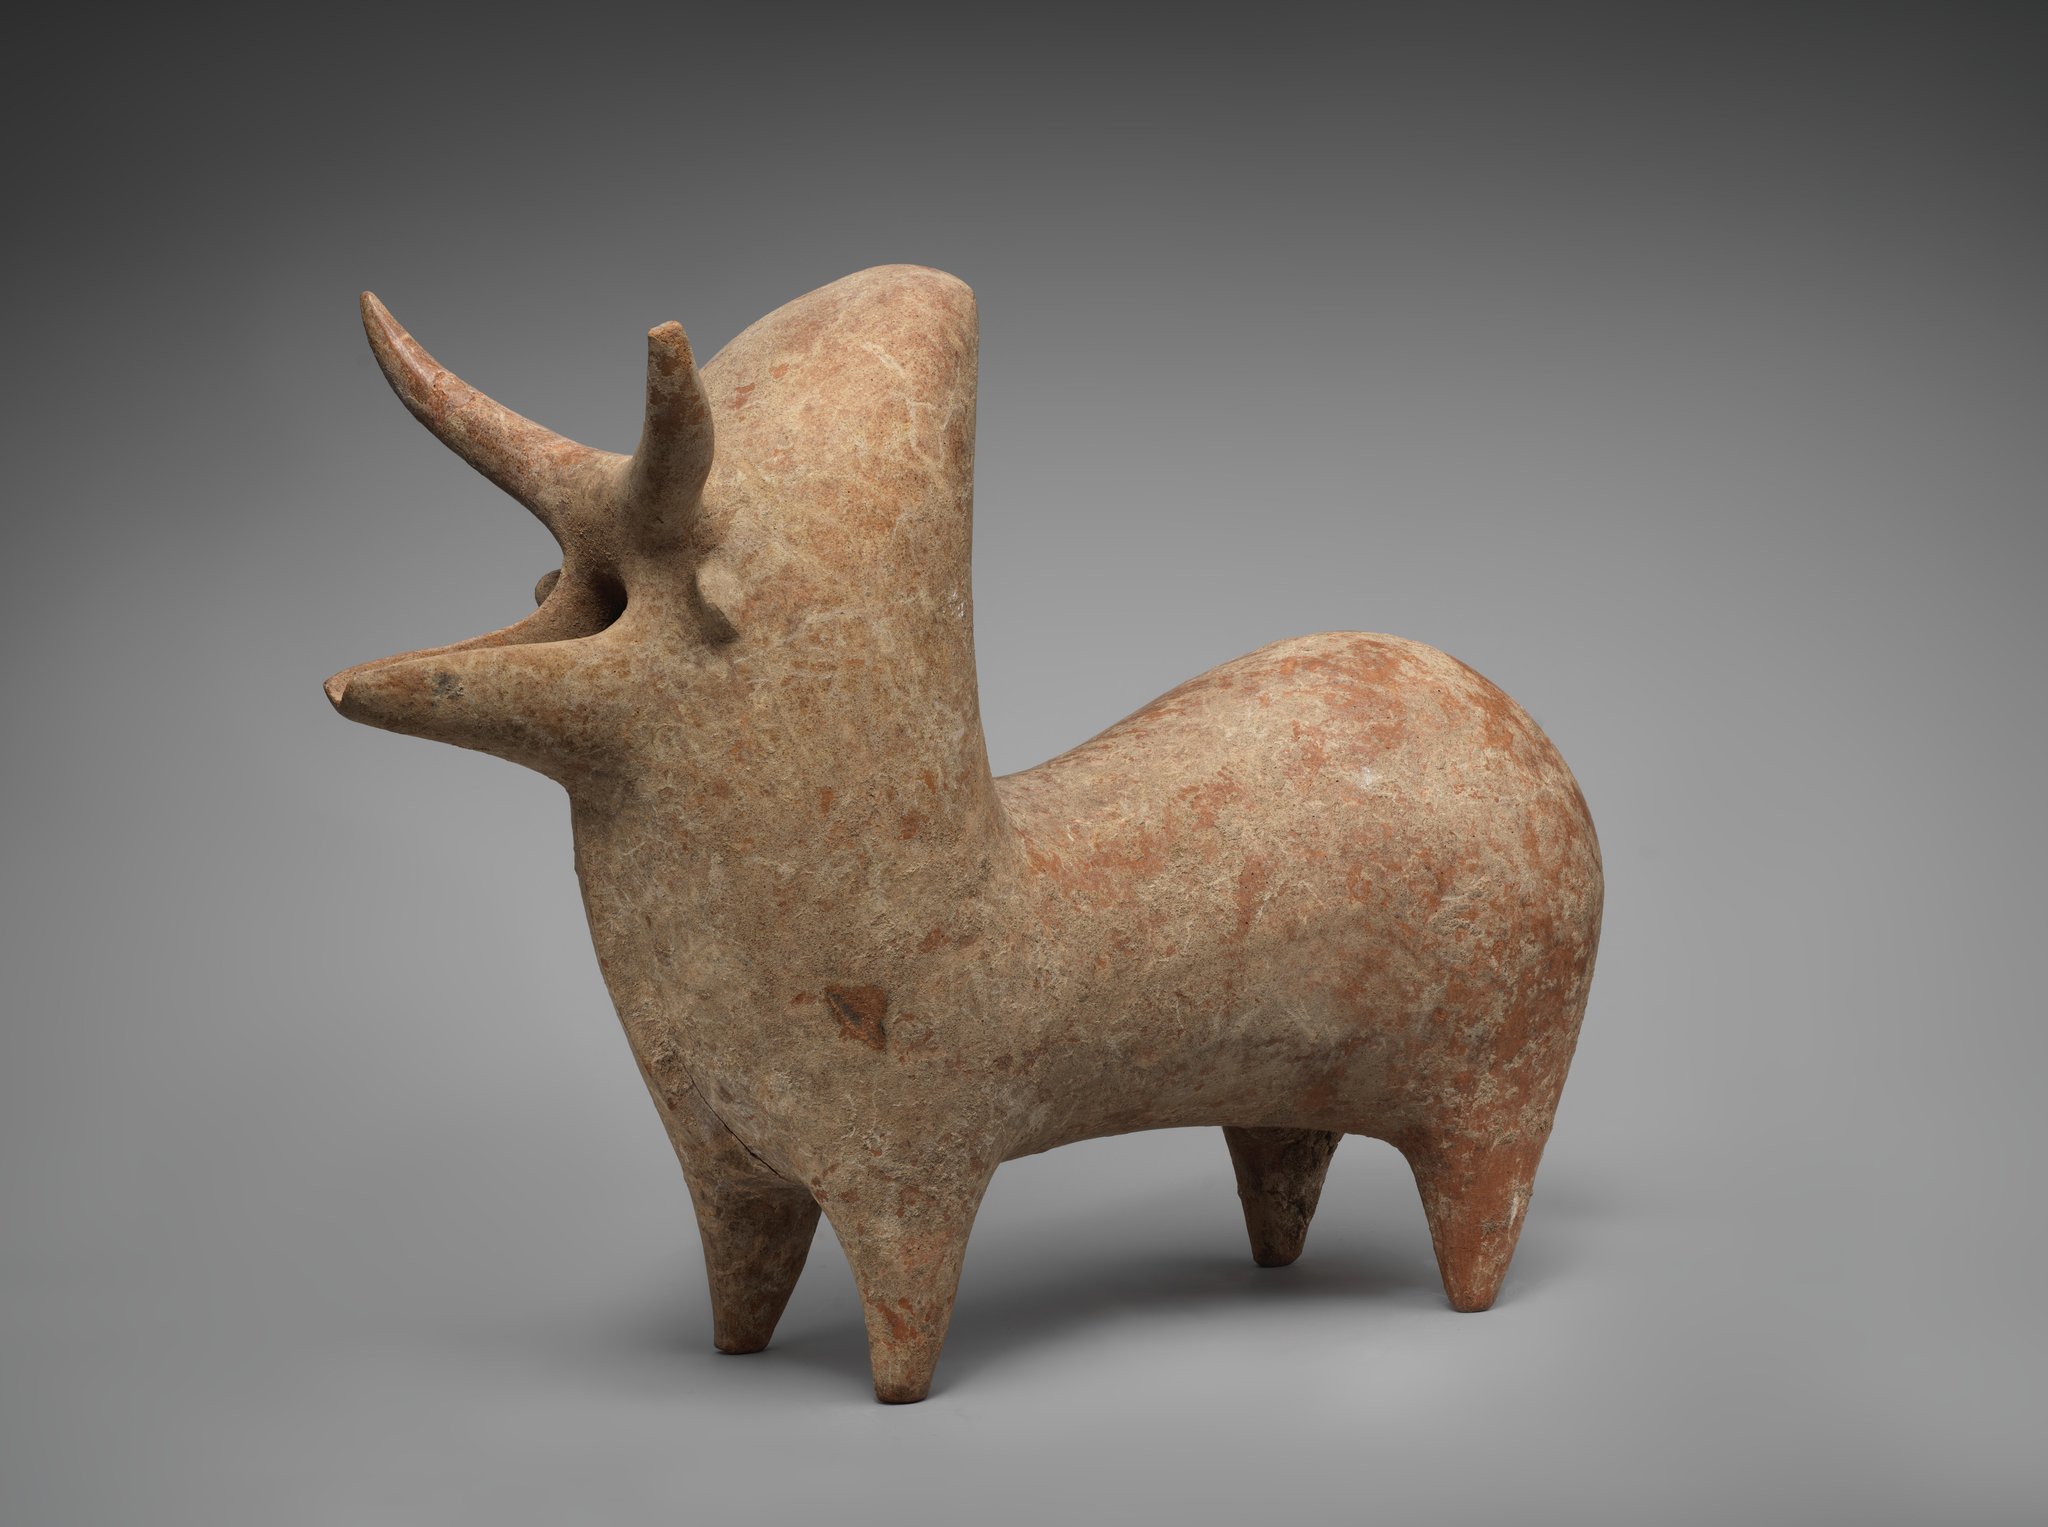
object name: vessel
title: Spouted vessel in the form of a zebu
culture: iranian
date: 1000-668 BCE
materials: ceramic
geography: northwestern iran, caspian region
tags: animals